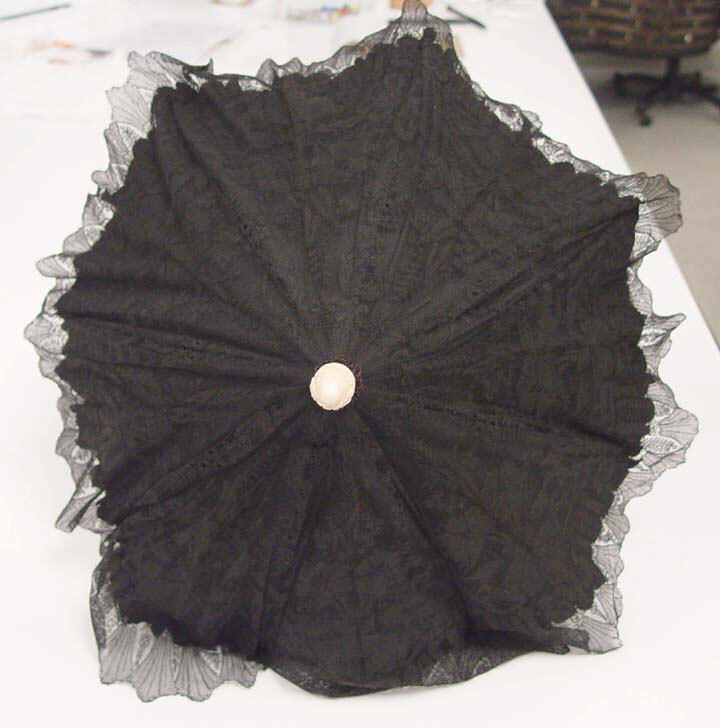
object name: parasol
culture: french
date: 1860-1869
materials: silk